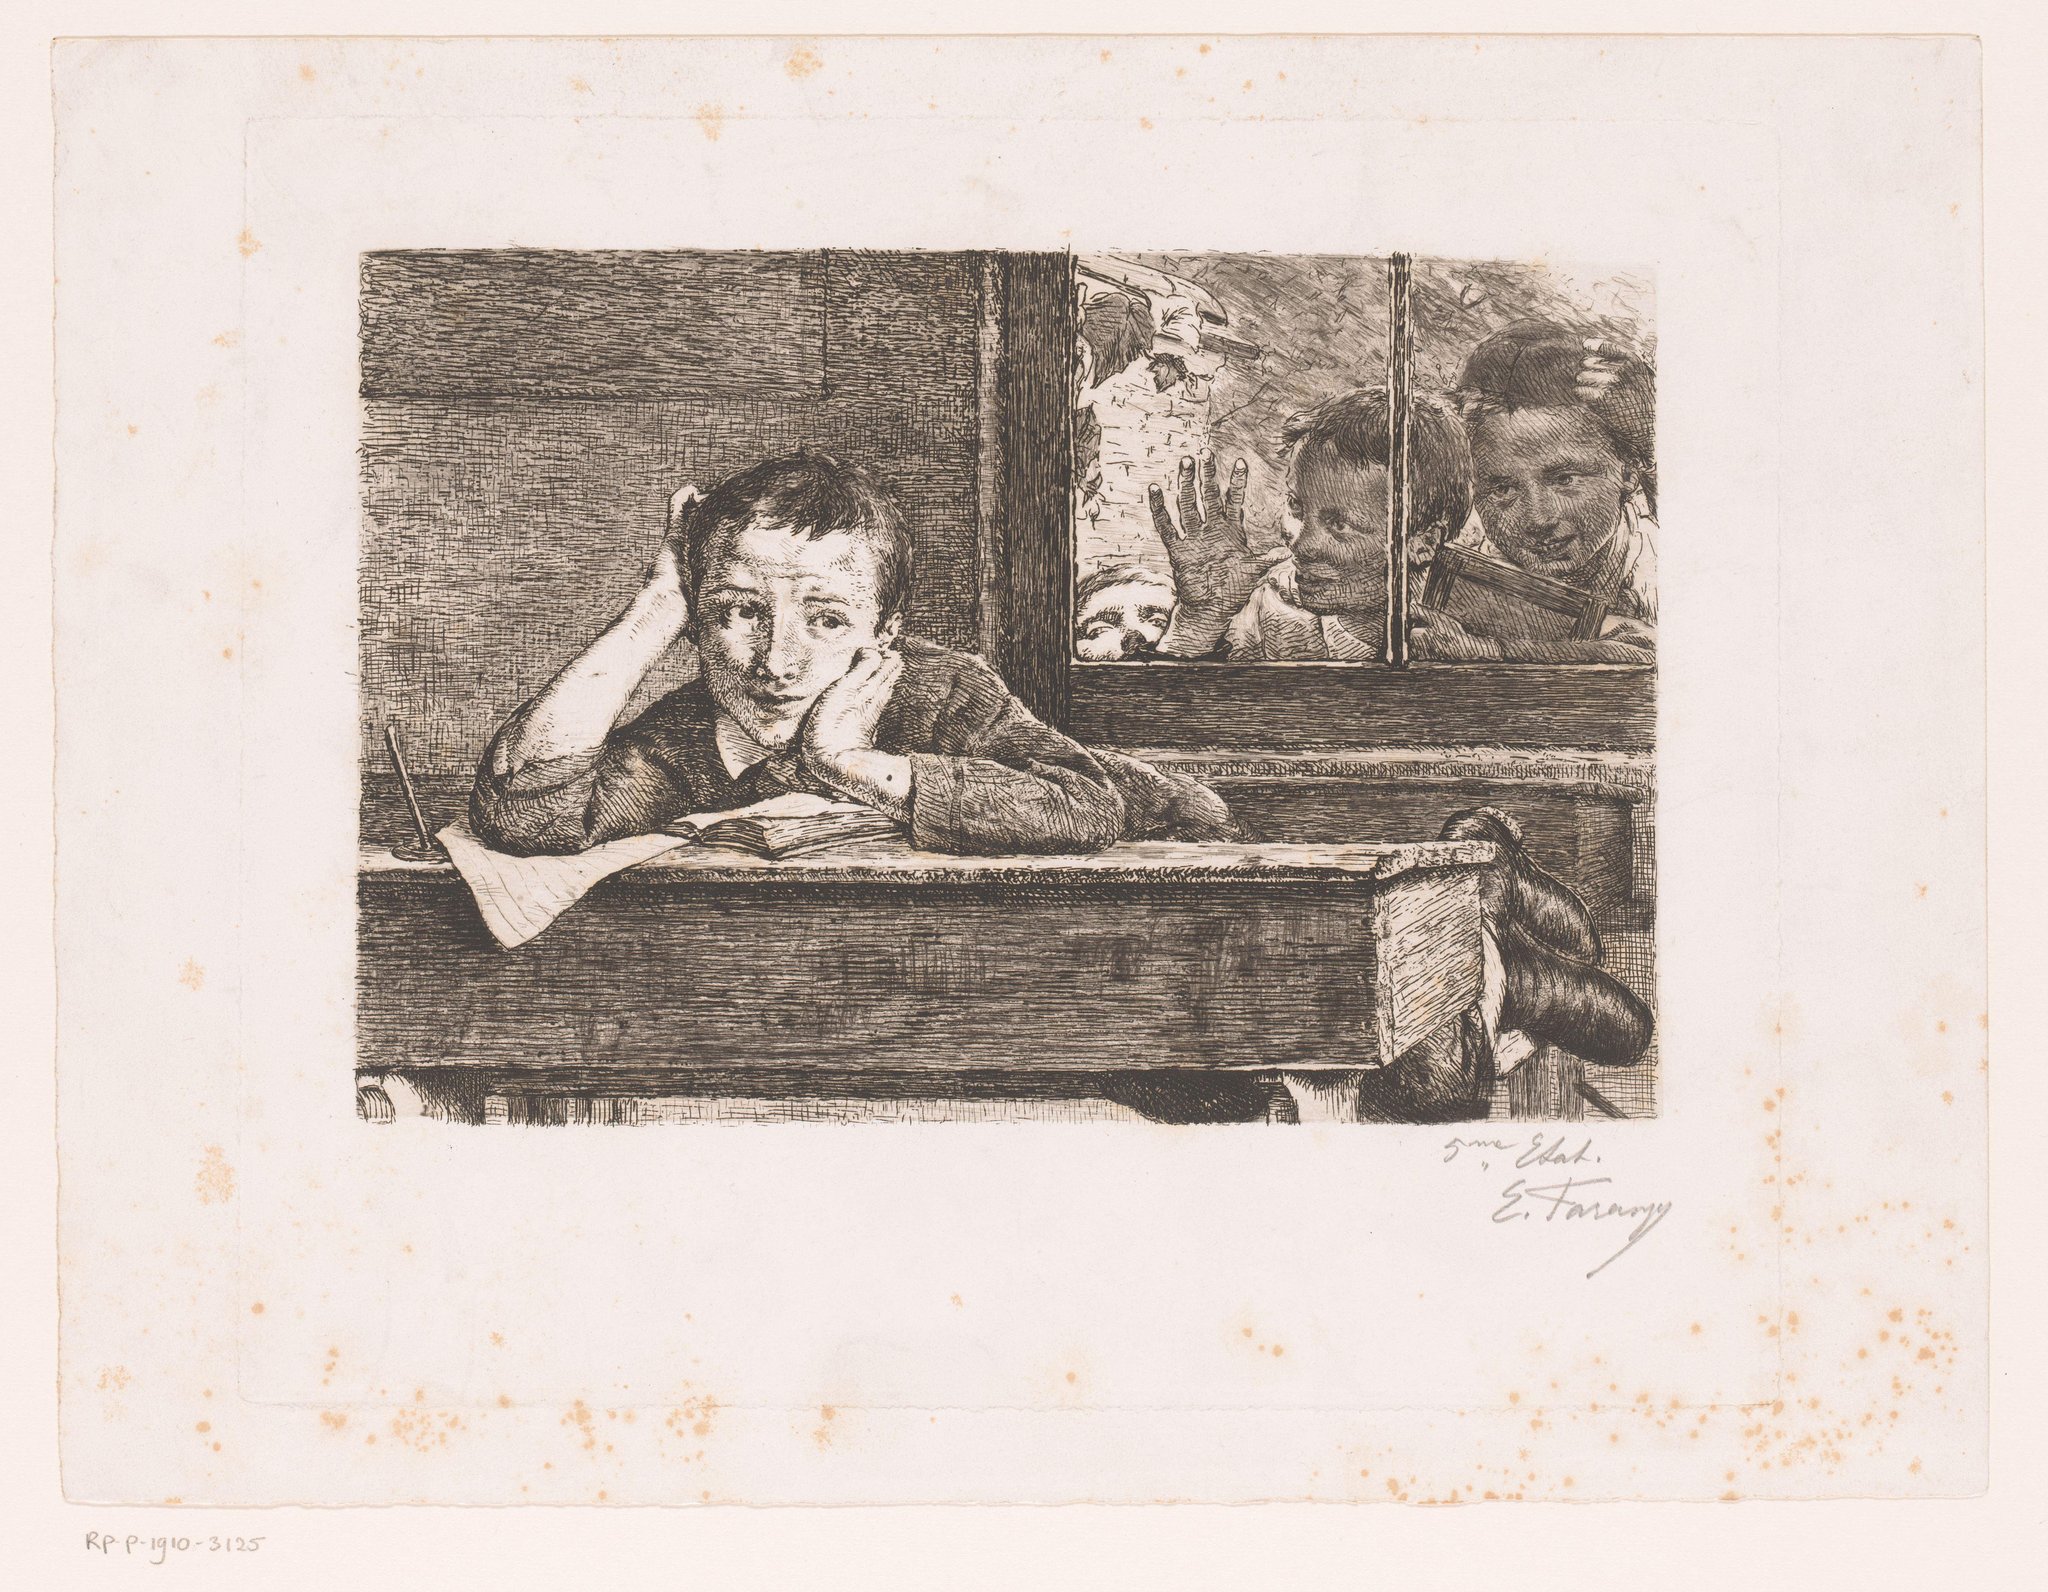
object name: print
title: Drie kinderen kijken door een raam naar een jongen die over een schoolbank hangt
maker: edgard farasyn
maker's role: print maker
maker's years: 1858-1938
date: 1868-1910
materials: paper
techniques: etching, intaglio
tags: writing-table, writing-desk, child (+ four persons), closed window, elementary school; class, form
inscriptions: inscription: ‘5me Etat’, collector's mark: Lugt 2228